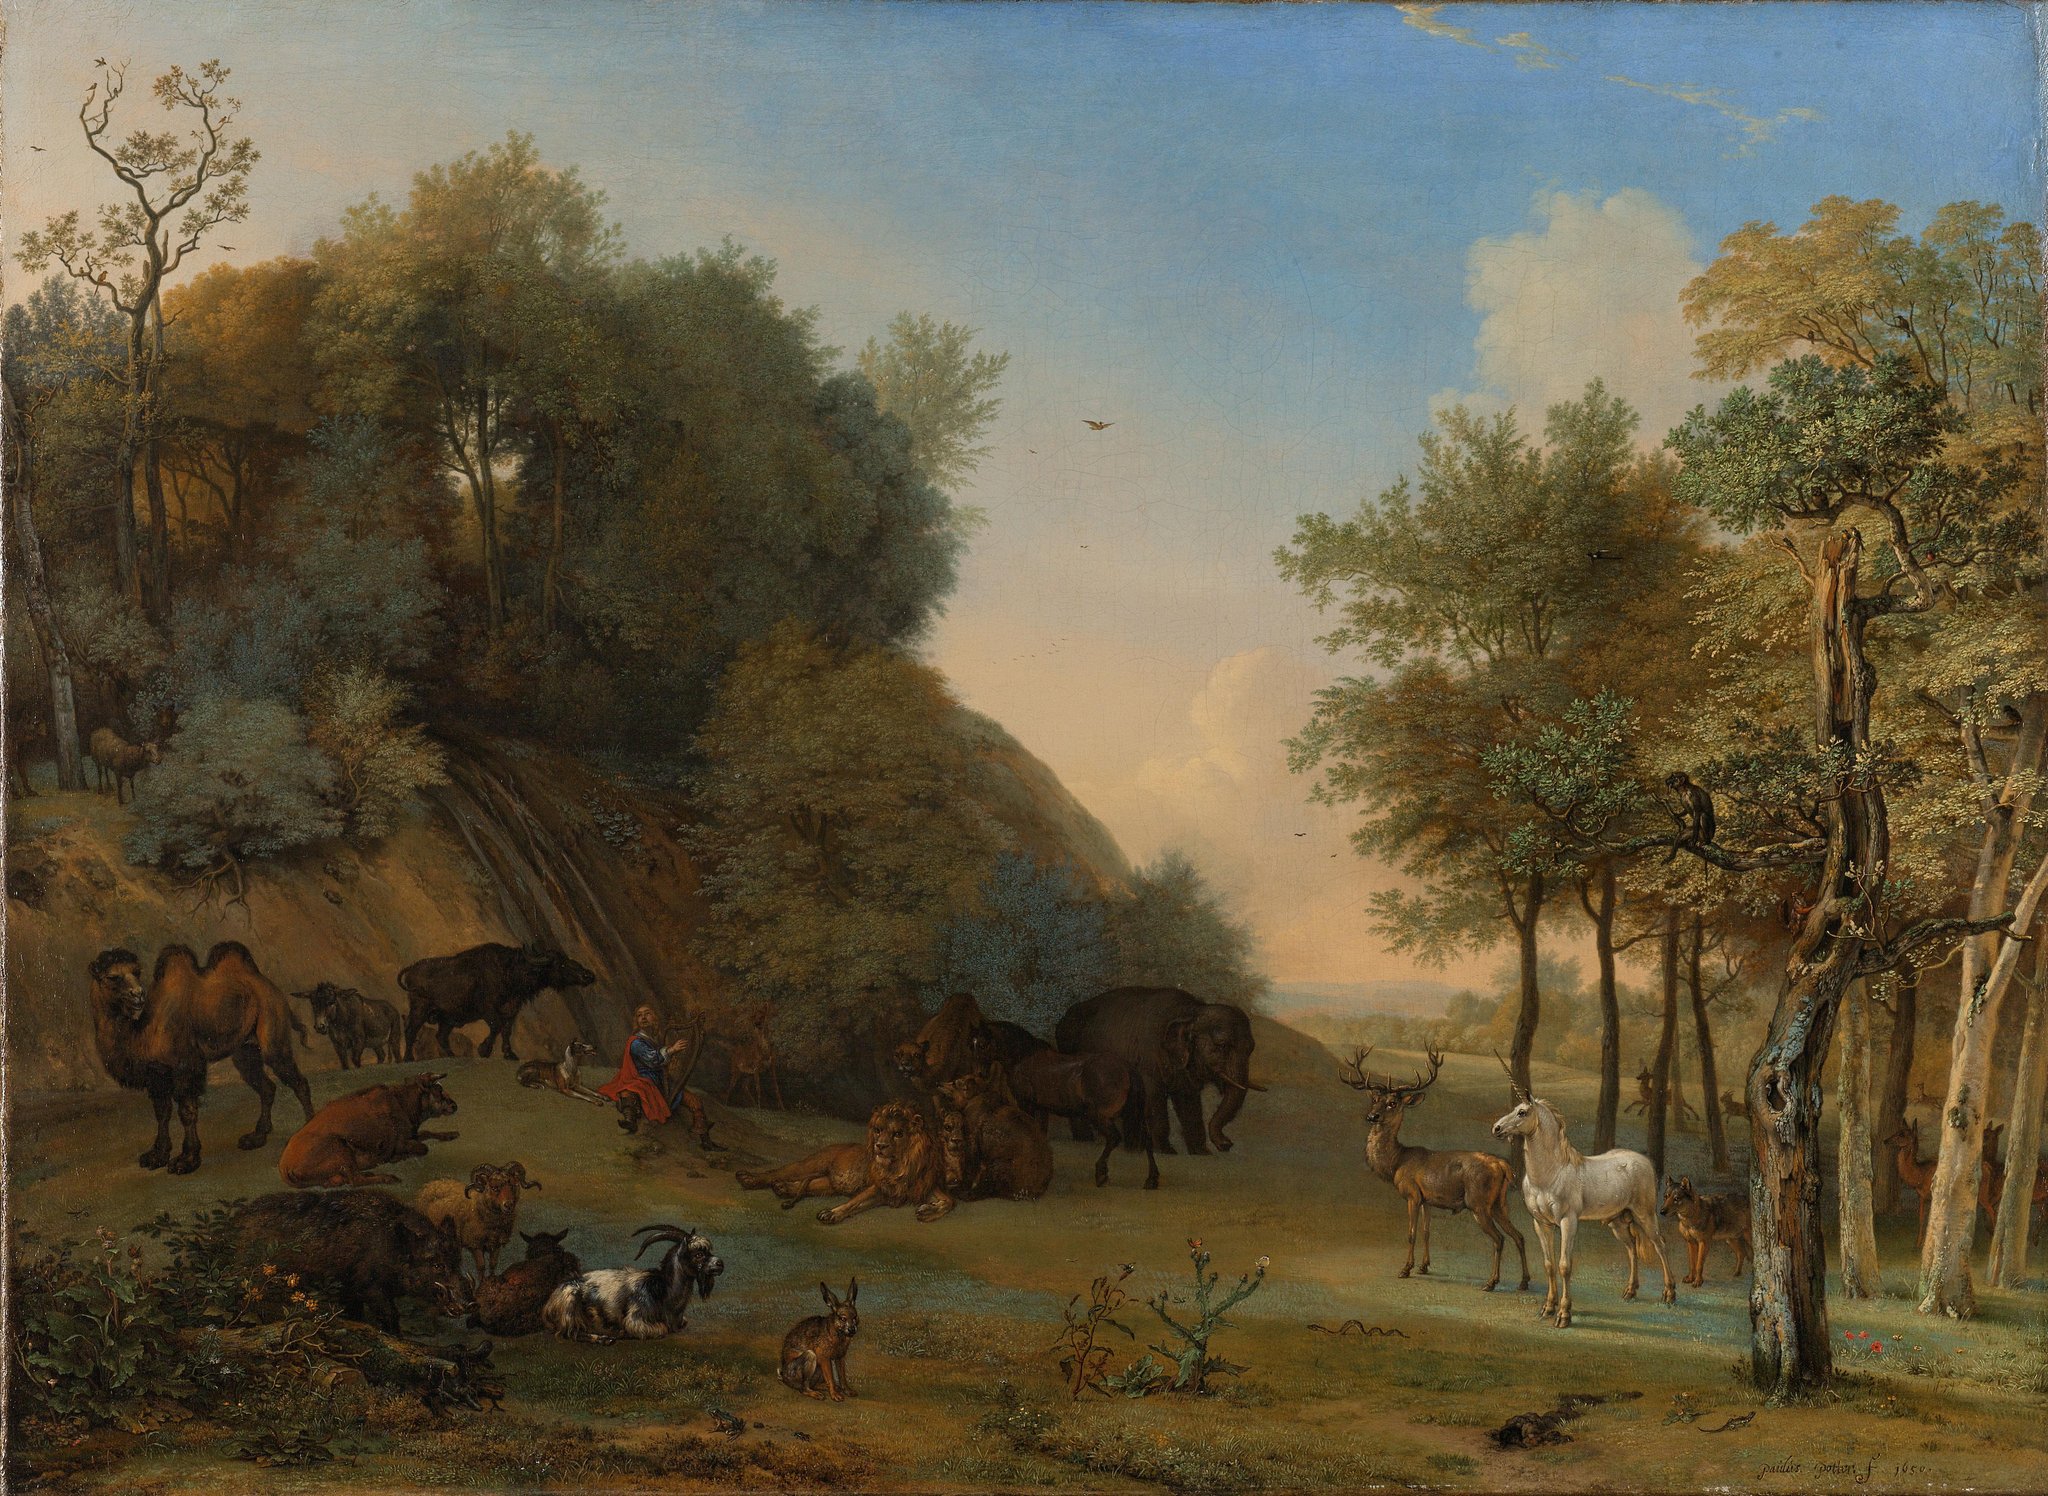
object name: painting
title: Orpheus and the Animals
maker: paulus potter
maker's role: draughtsman, painter, print maker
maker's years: 1625-1654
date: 1650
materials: canvas, oil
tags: orpheus playing the lyre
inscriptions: signature and date: ‘Paulus Potter f 1650’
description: The Classical poet Ovid described how Orpheus en-chanted nature with his wonderful lyre music. This theme was popular among 17th-century animal painters because it gave them a chance to depict many different sorts of animals. Here Potter demonstrates that his repertoire encompassed more than the usual farm animals. He painted dozens of native and exotic beasts. In the middle Orpheus is strumming his harp.